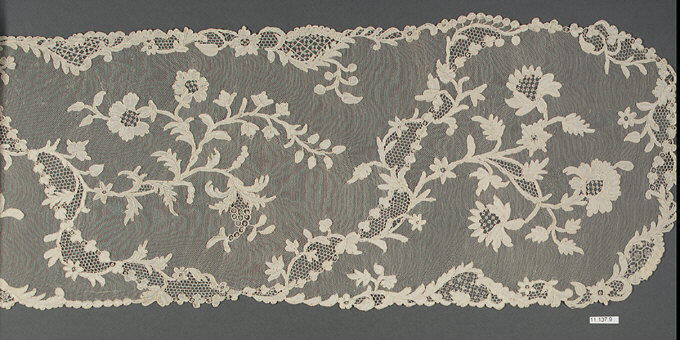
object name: scarf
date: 1701-1800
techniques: lace